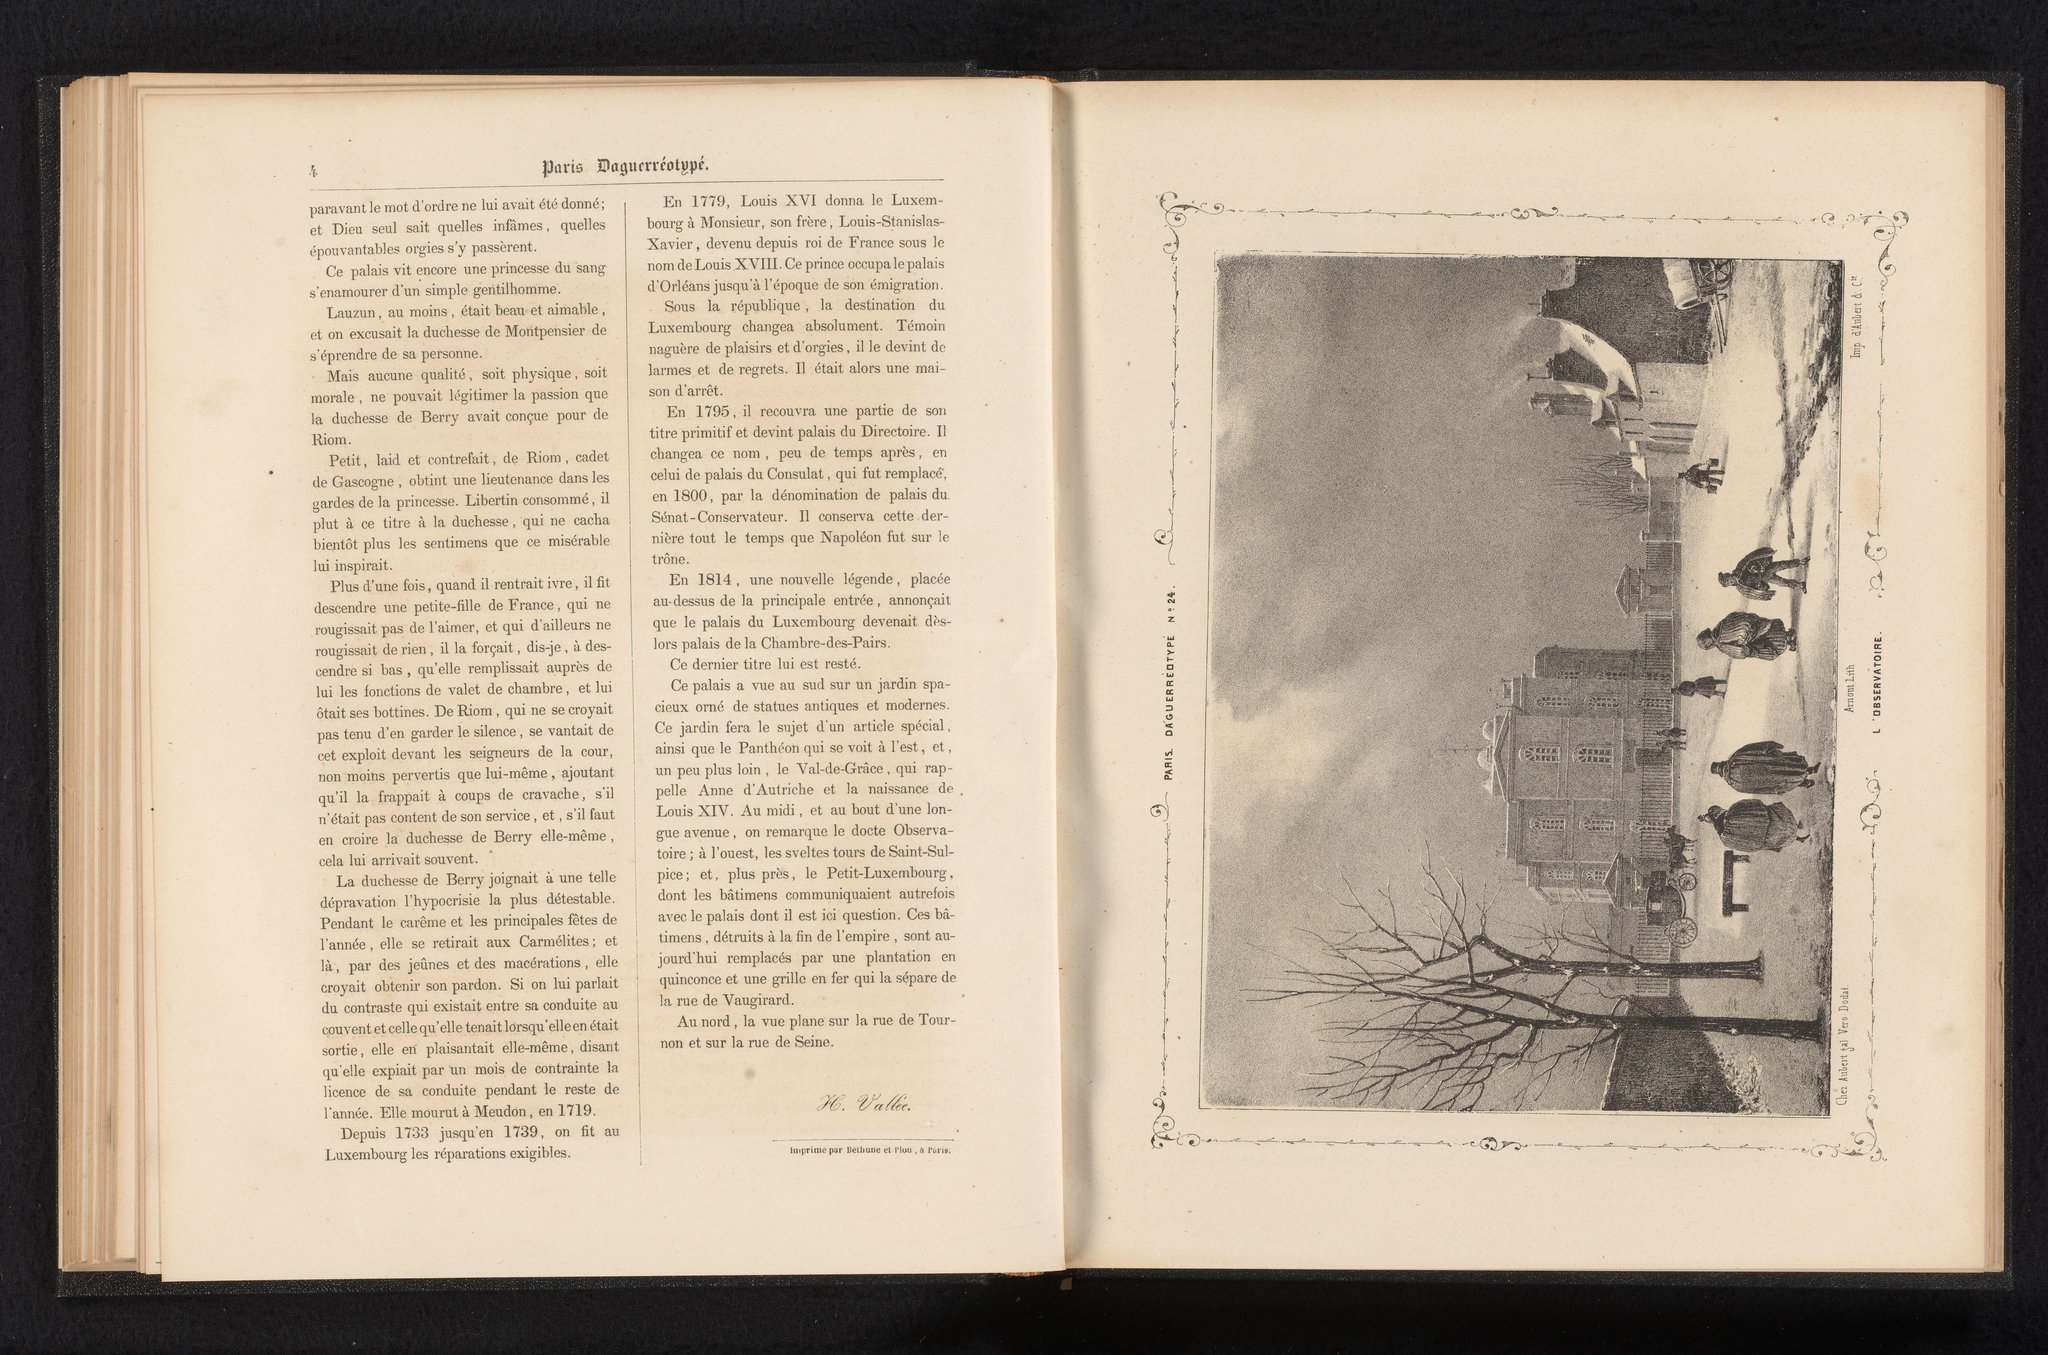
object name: print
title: Observatorium van Parijs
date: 1839-1840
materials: paper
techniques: lithograph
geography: paris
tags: observatory (~ astronomy)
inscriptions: inscription: ‘PARIS DAGUERRÉOTYPÉ No. 24.’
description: Prent op vijfennegentigste ongenummerde pagina.